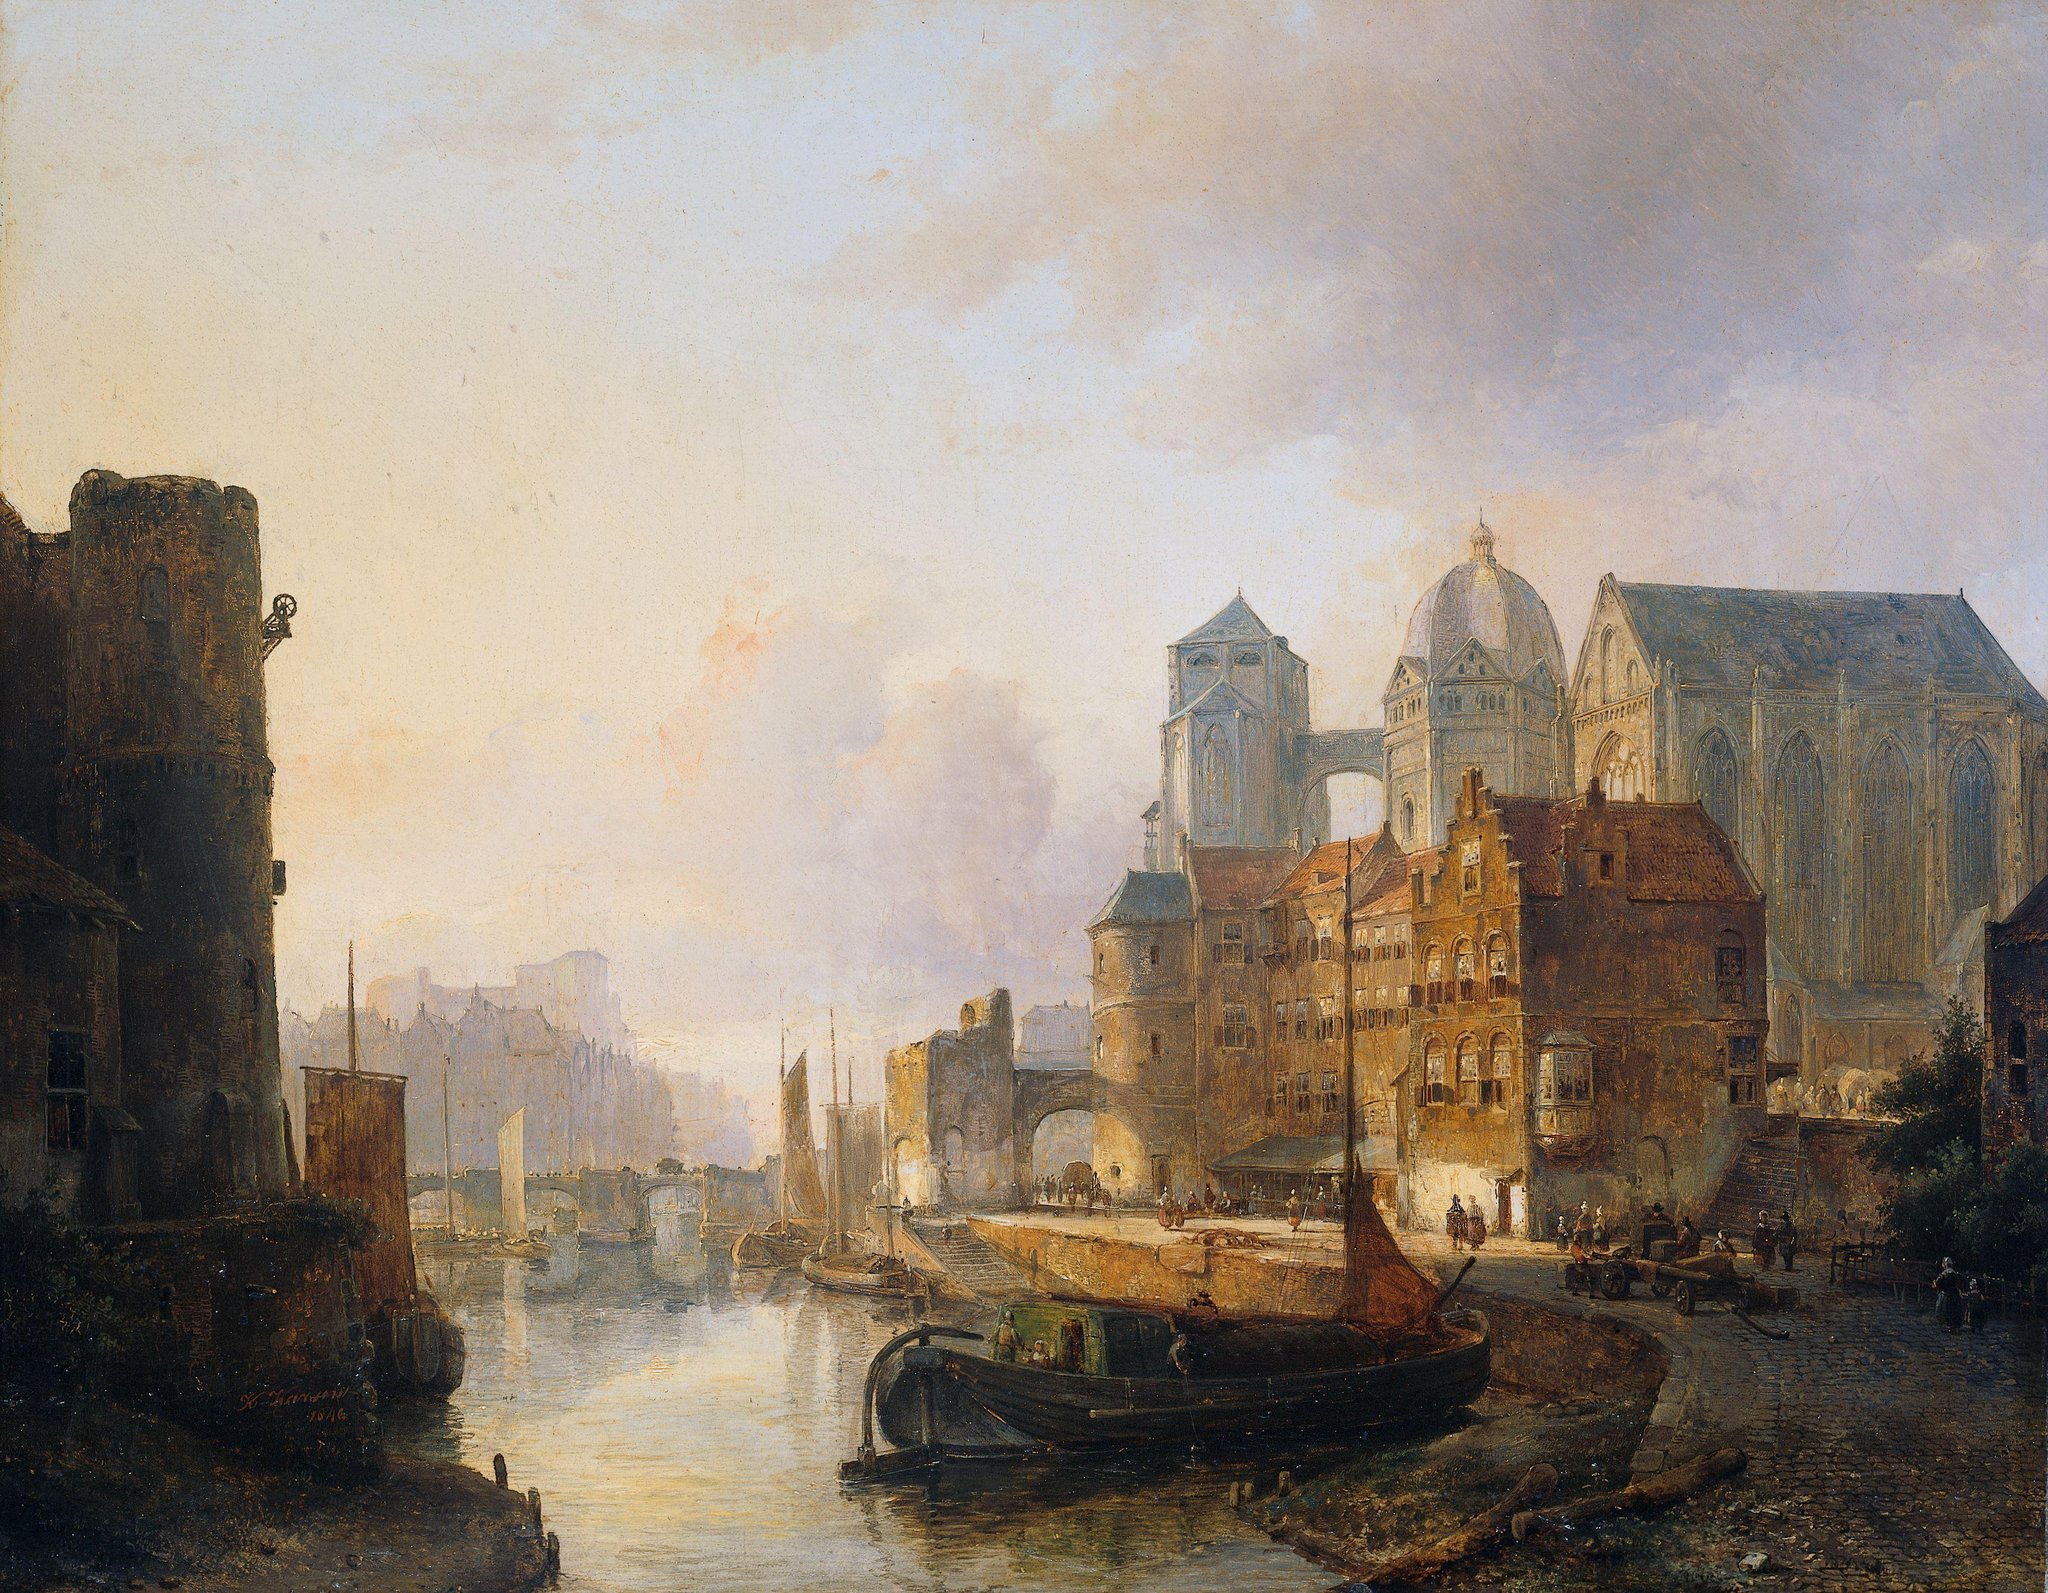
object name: painting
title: View of a Town on a River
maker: kasparus karsen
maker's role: draughtsman, painter, print maker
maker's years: 1810-1896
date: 1846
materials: oil, panel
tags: dom van aken, aken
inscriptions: signature and date: ‘K. Karsen 1846’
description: Gefantaseerd gezicht in een stad aan een rivier met de Dom te Aken. Aan de kade liggen verschillende schuiten. In de verte een sten brug. Links een vervallen toren.